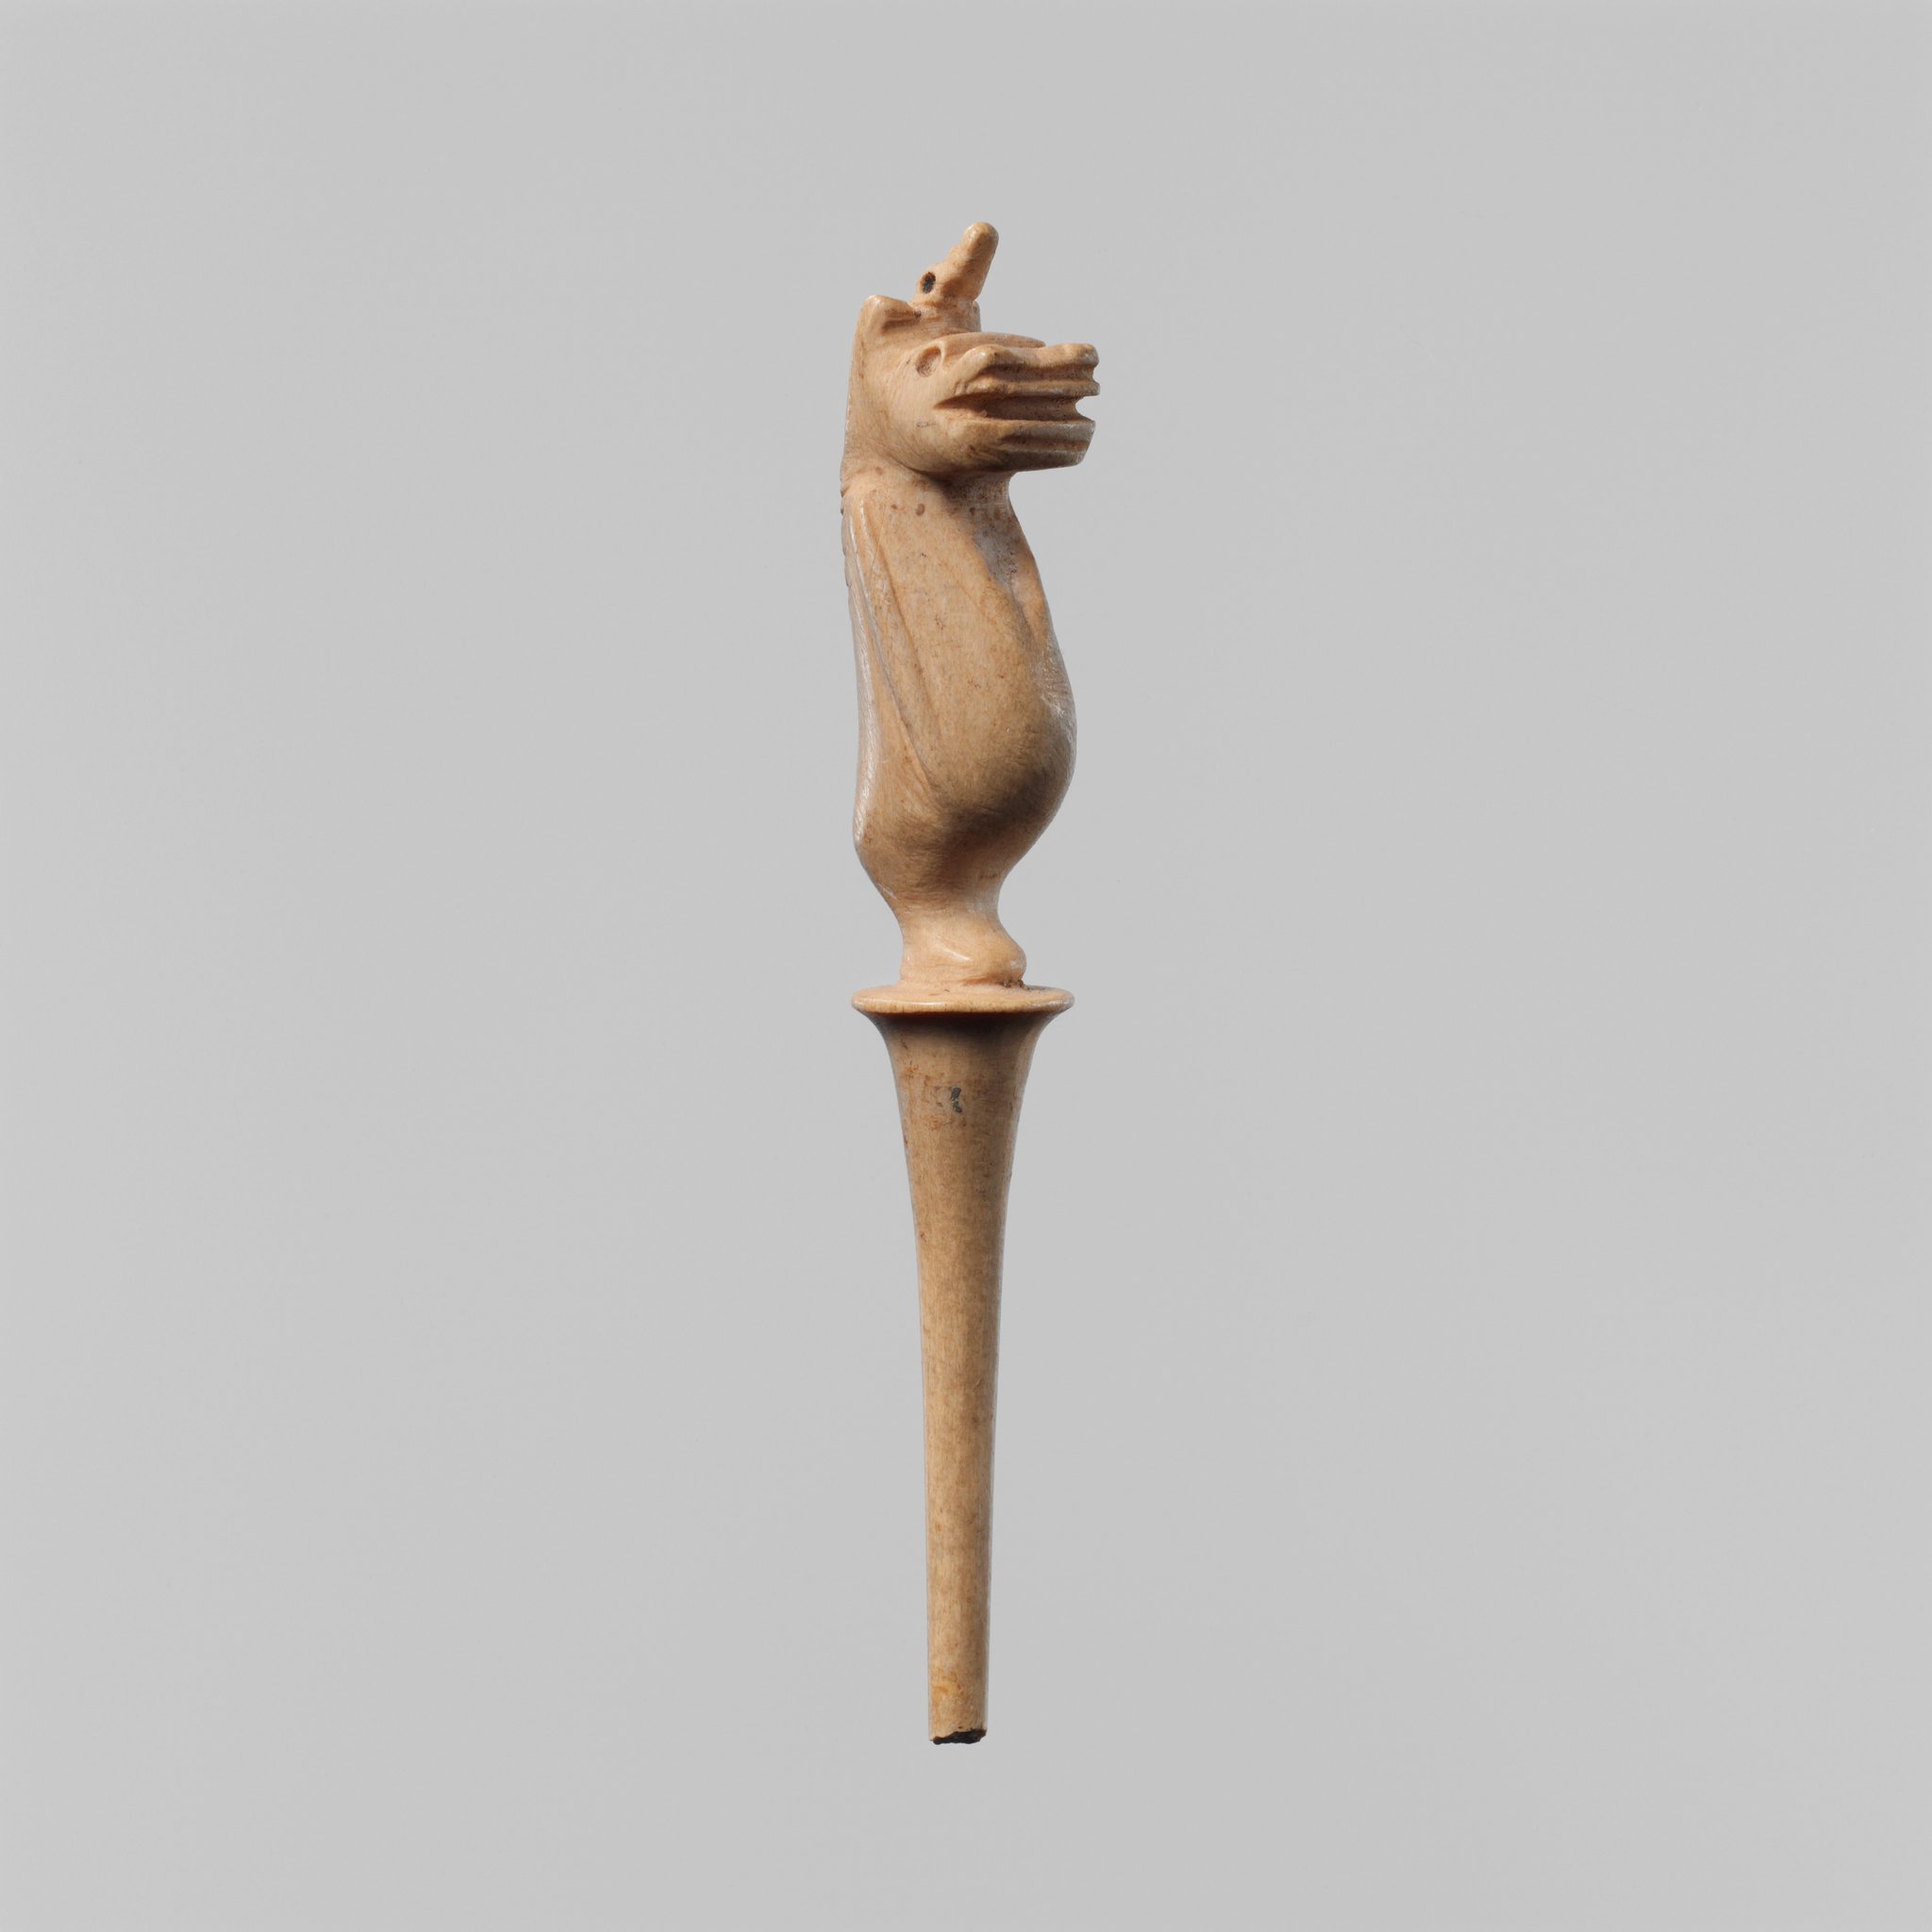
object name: hairpin, hippopotamus, taweret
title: Hairpin with a Figure of a Hippopotamus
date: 1981-1640 BCE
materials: bone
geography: egypt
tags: hippos